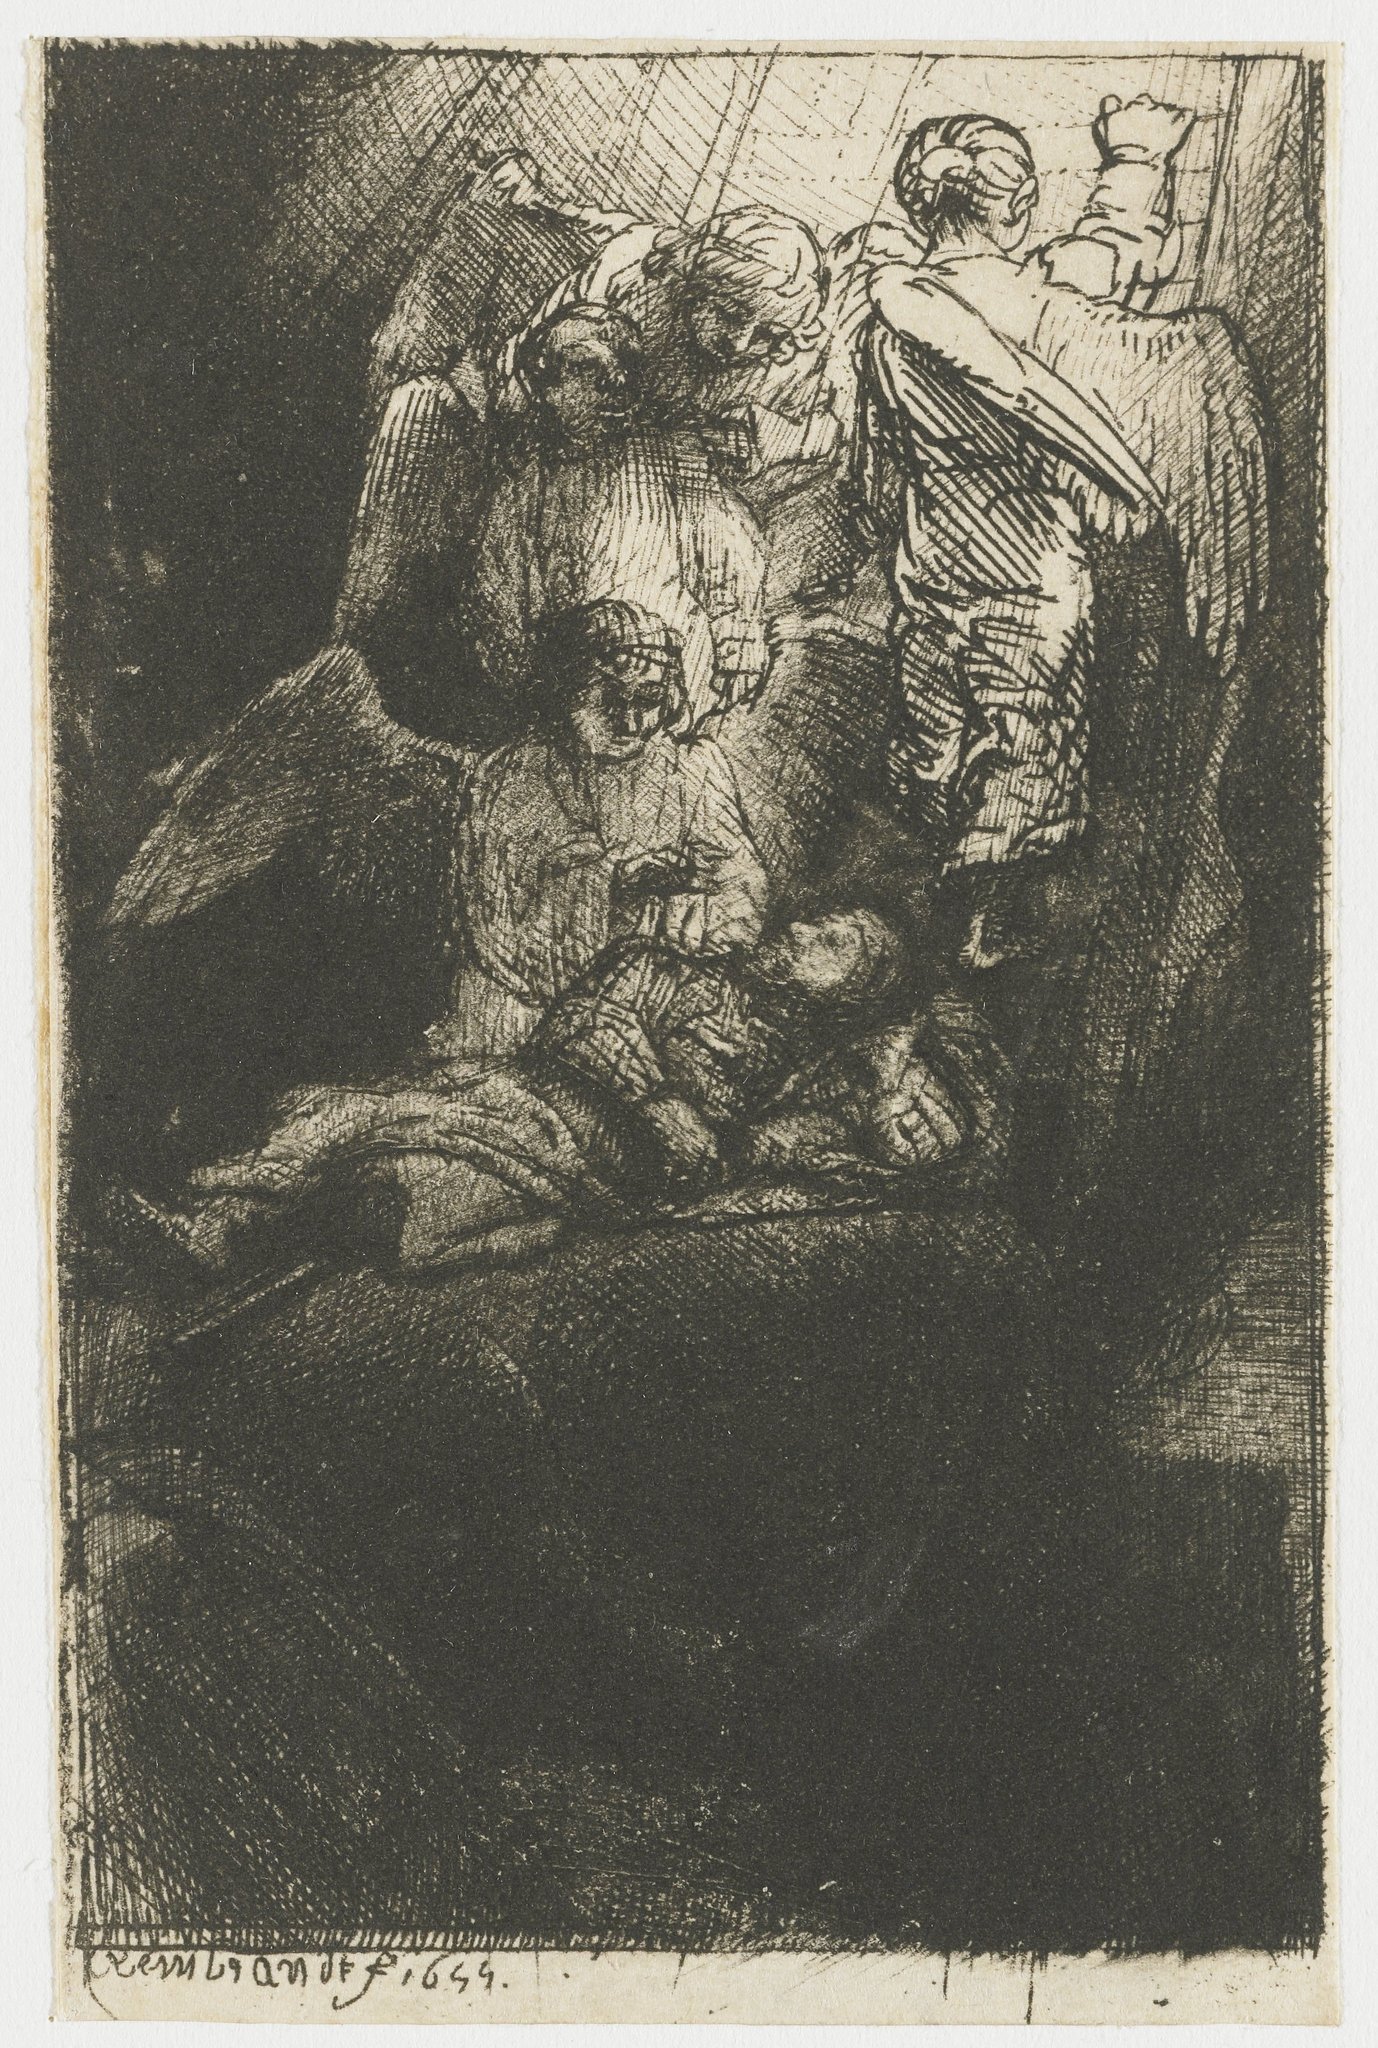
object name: print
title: Jacob's ladder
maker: rembrandt van rijn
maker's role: draughtsman, painter, print maker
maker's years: 1606-1669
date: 1655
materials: paper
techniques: drypoint, etching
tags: the dream of jacob: while sleeping on the ground with a stone for pillow jacob sees a ladder reaching from earth to heaven with angels going up and down; usually with god at the top of the ladder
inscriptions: collector's mark: Lugt 240, signature and date: ‘Rembrandt f 1655’